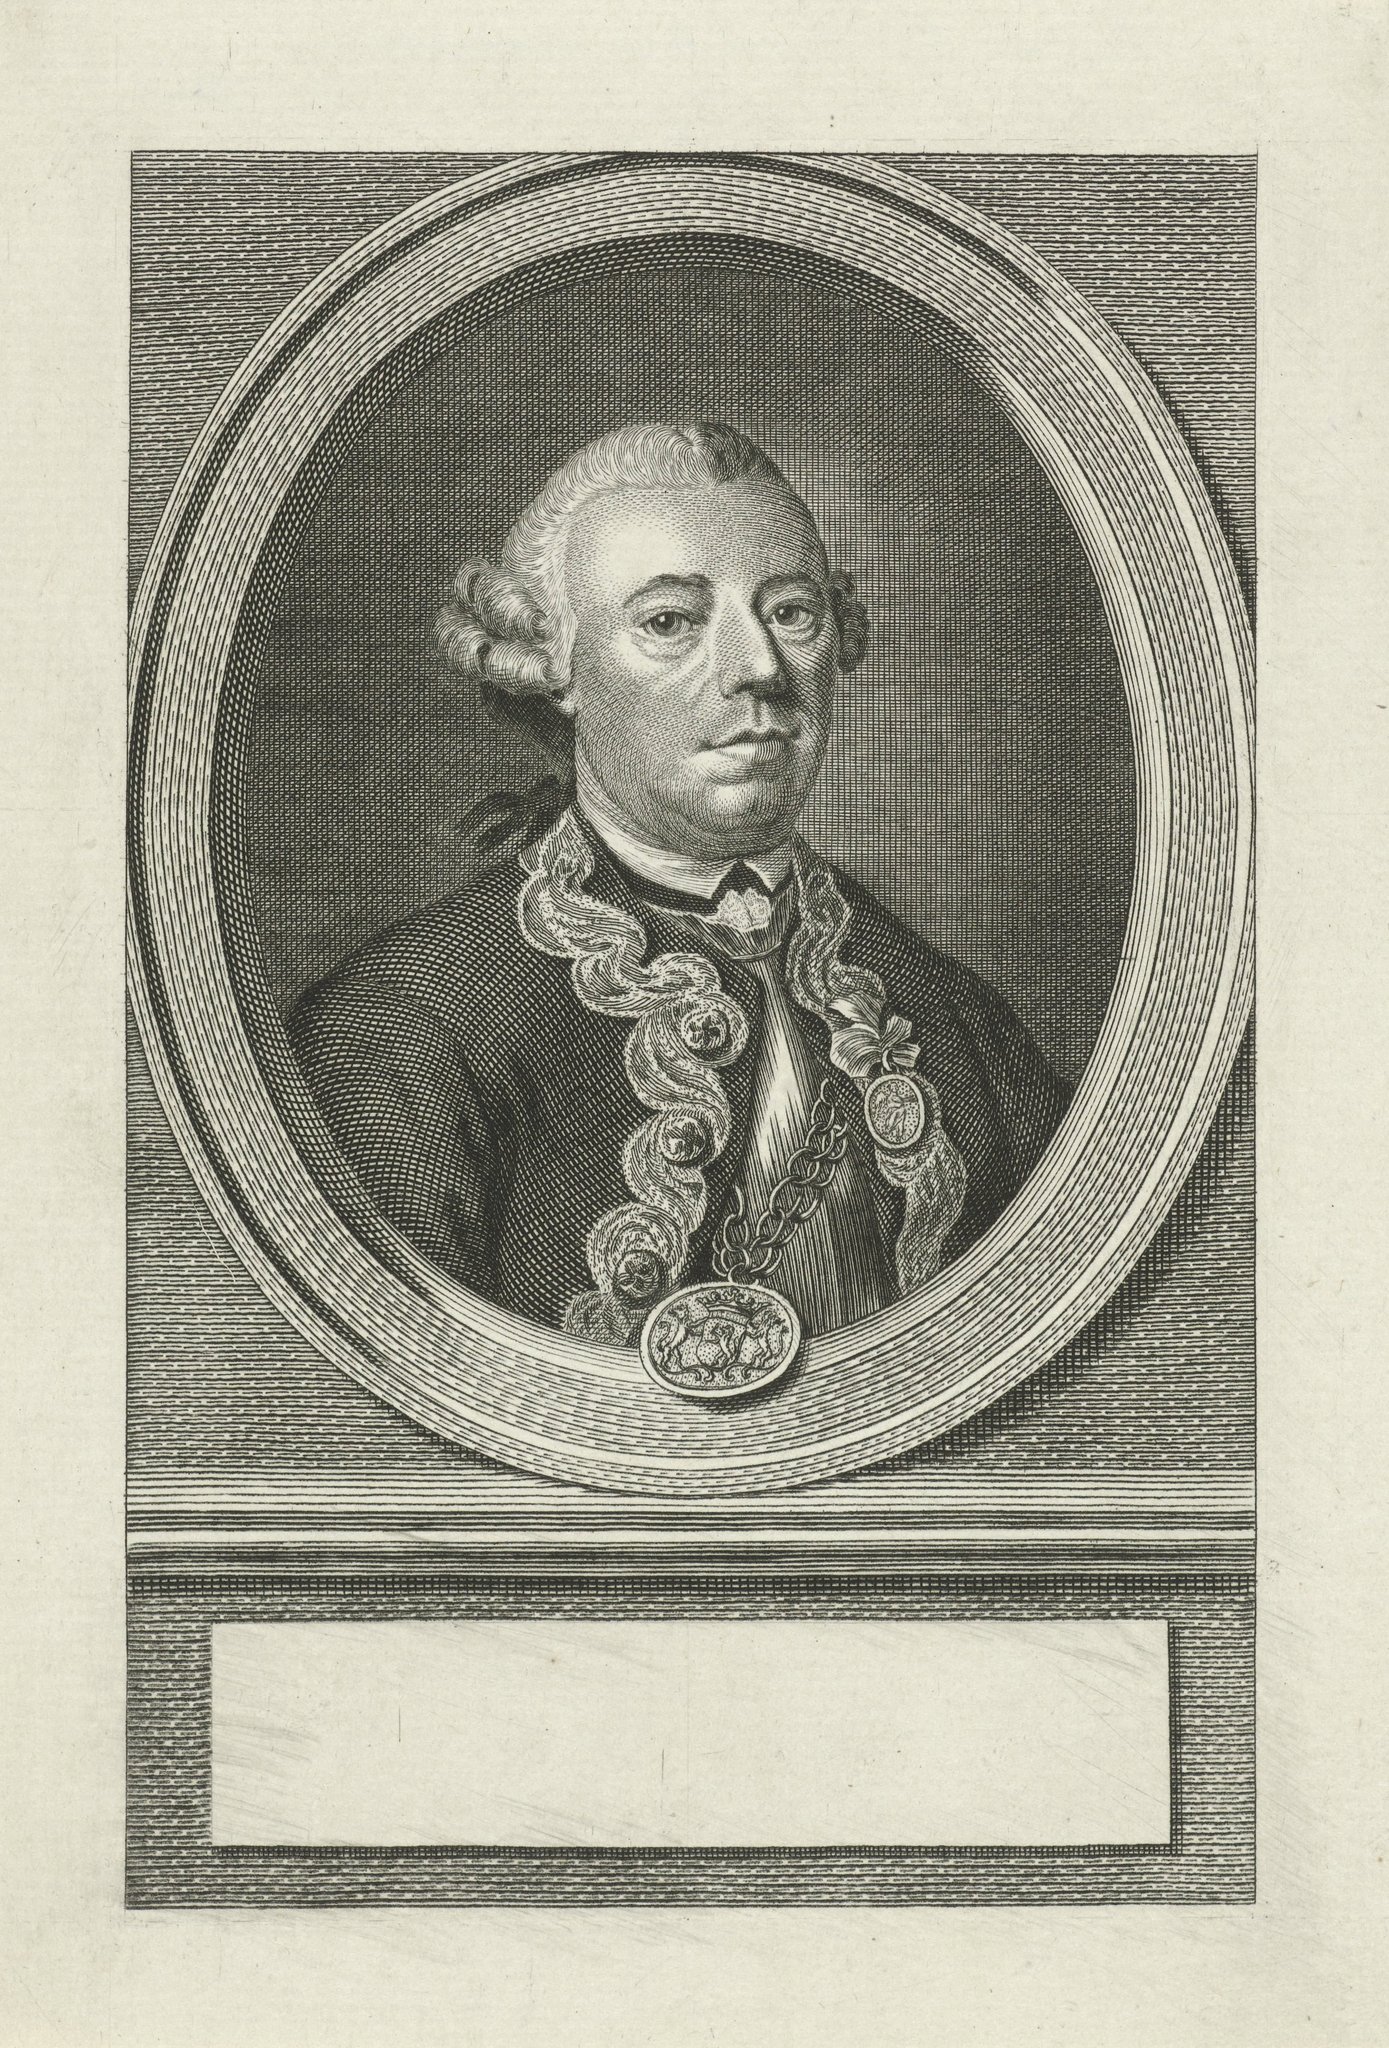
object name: print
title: Portret van Johan Arnold Zoutman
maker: pieter willem van megen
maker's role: print maker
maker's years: 1750-1785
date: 1775-1776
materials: paper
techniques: engraving, etching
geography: the hague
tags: johan arnold zoutman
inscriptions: collector's mark: Lugt 2228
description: Latere staat prent waarschijnlijk uit: Nomsz., Johannes. Mengelwerk. Amsterdam: s.n., 1776, dl. 3.